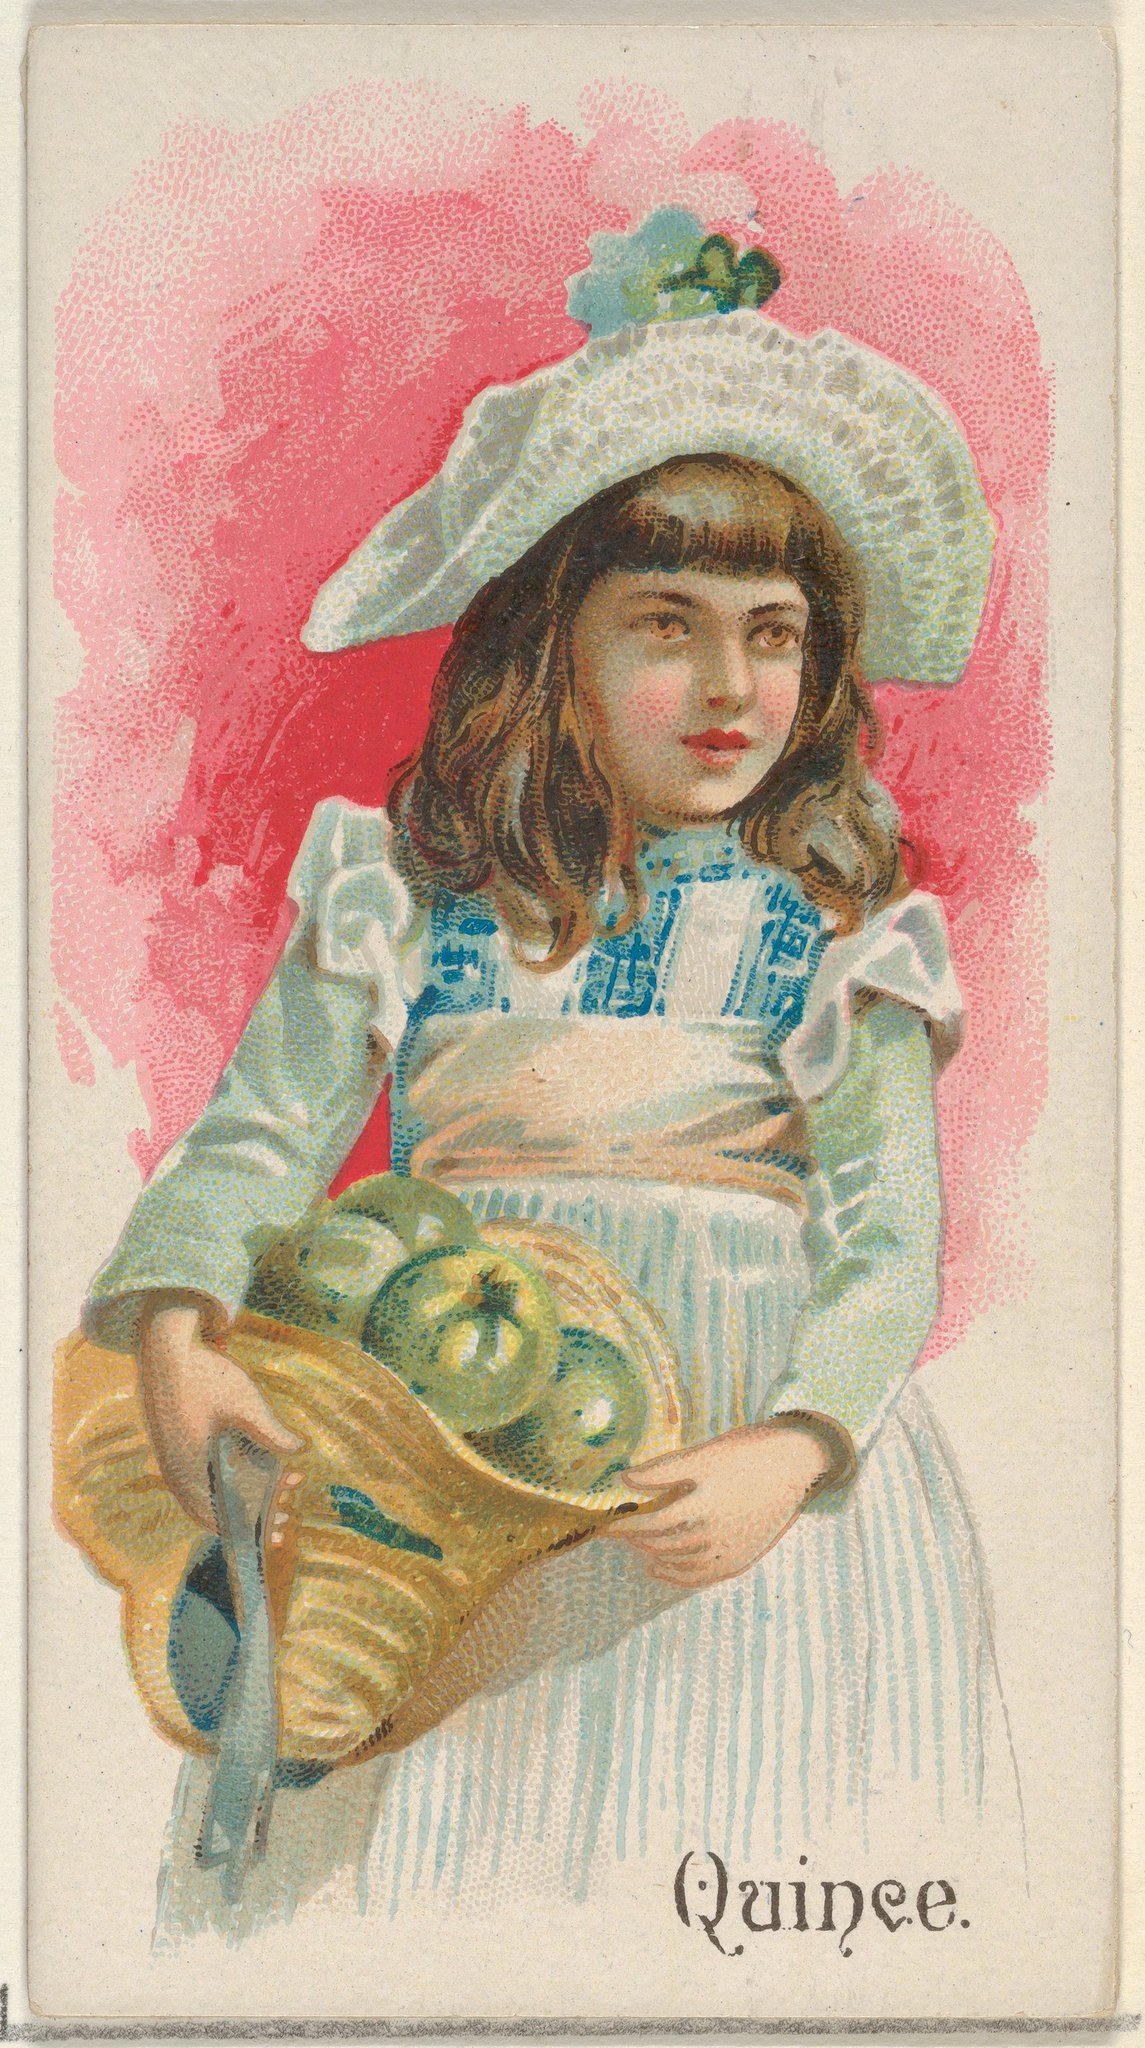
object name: print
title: Quince, from the Fruits series (N12) for Allen & Ginter Cigarettes Brands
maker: allen & ginter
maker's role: publisher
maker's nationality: american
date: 1891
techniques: color lithograph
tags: fruit,girls